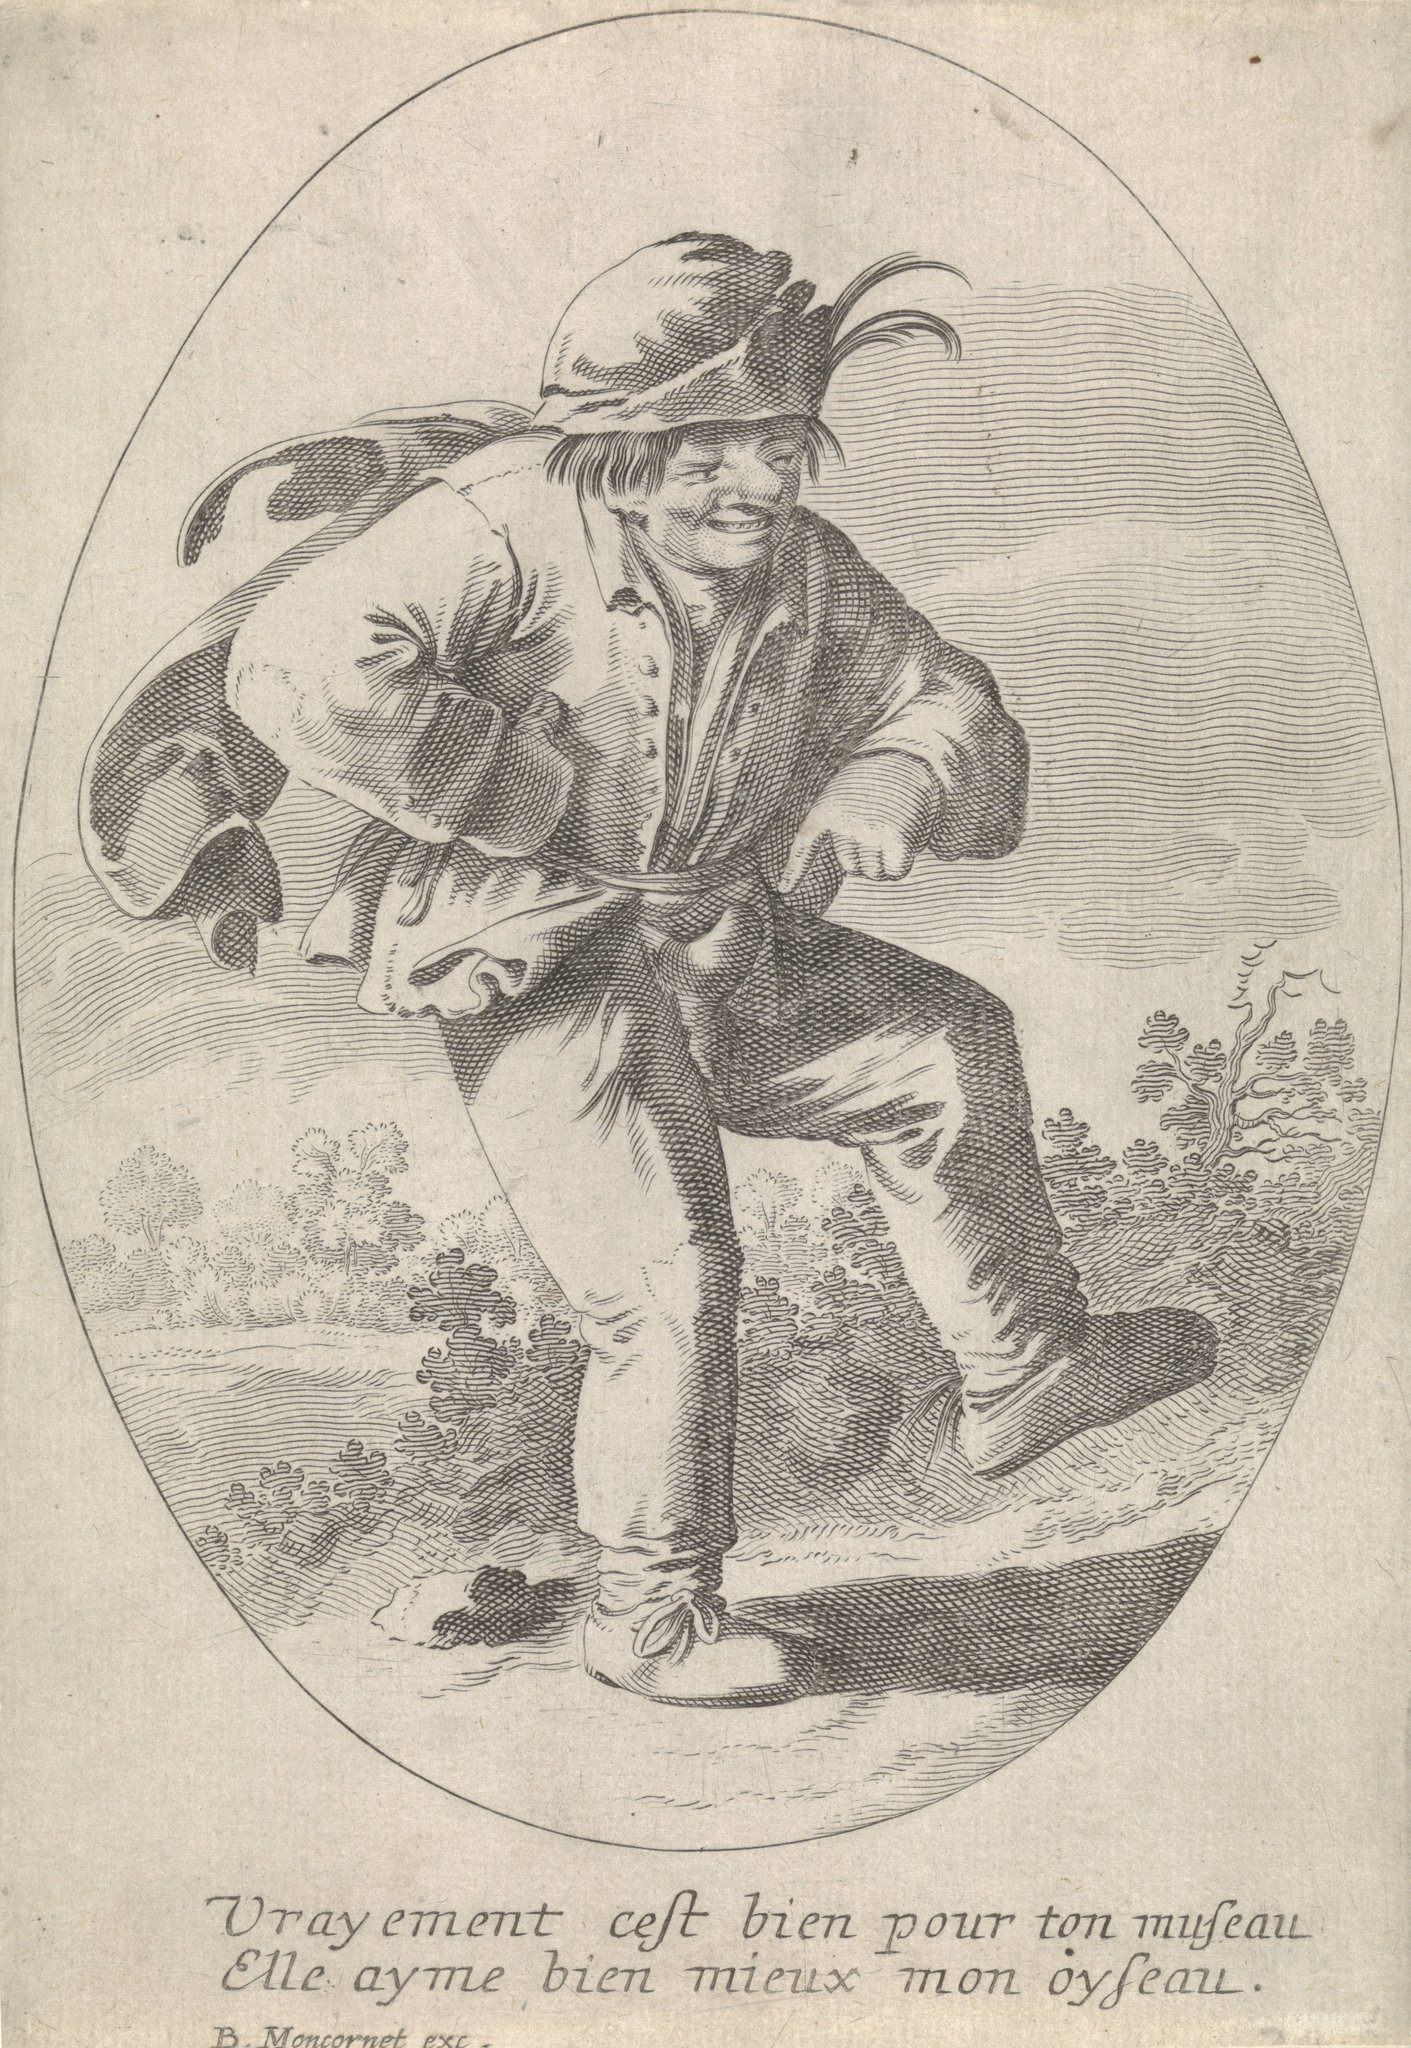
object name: print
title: Boeren en boerinnen in obscene houdingen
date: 1622-1668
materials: paper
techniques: engraving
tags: scabrous scenes, pornography (+ variant), gesture-language, farmers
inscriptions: collector's mark: Lugt 2228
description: Een dansende boer in een landschap wijst naar zijn omhoogstaande penis. Onder de ovale voorstelling een tweeregelig Frans vers.